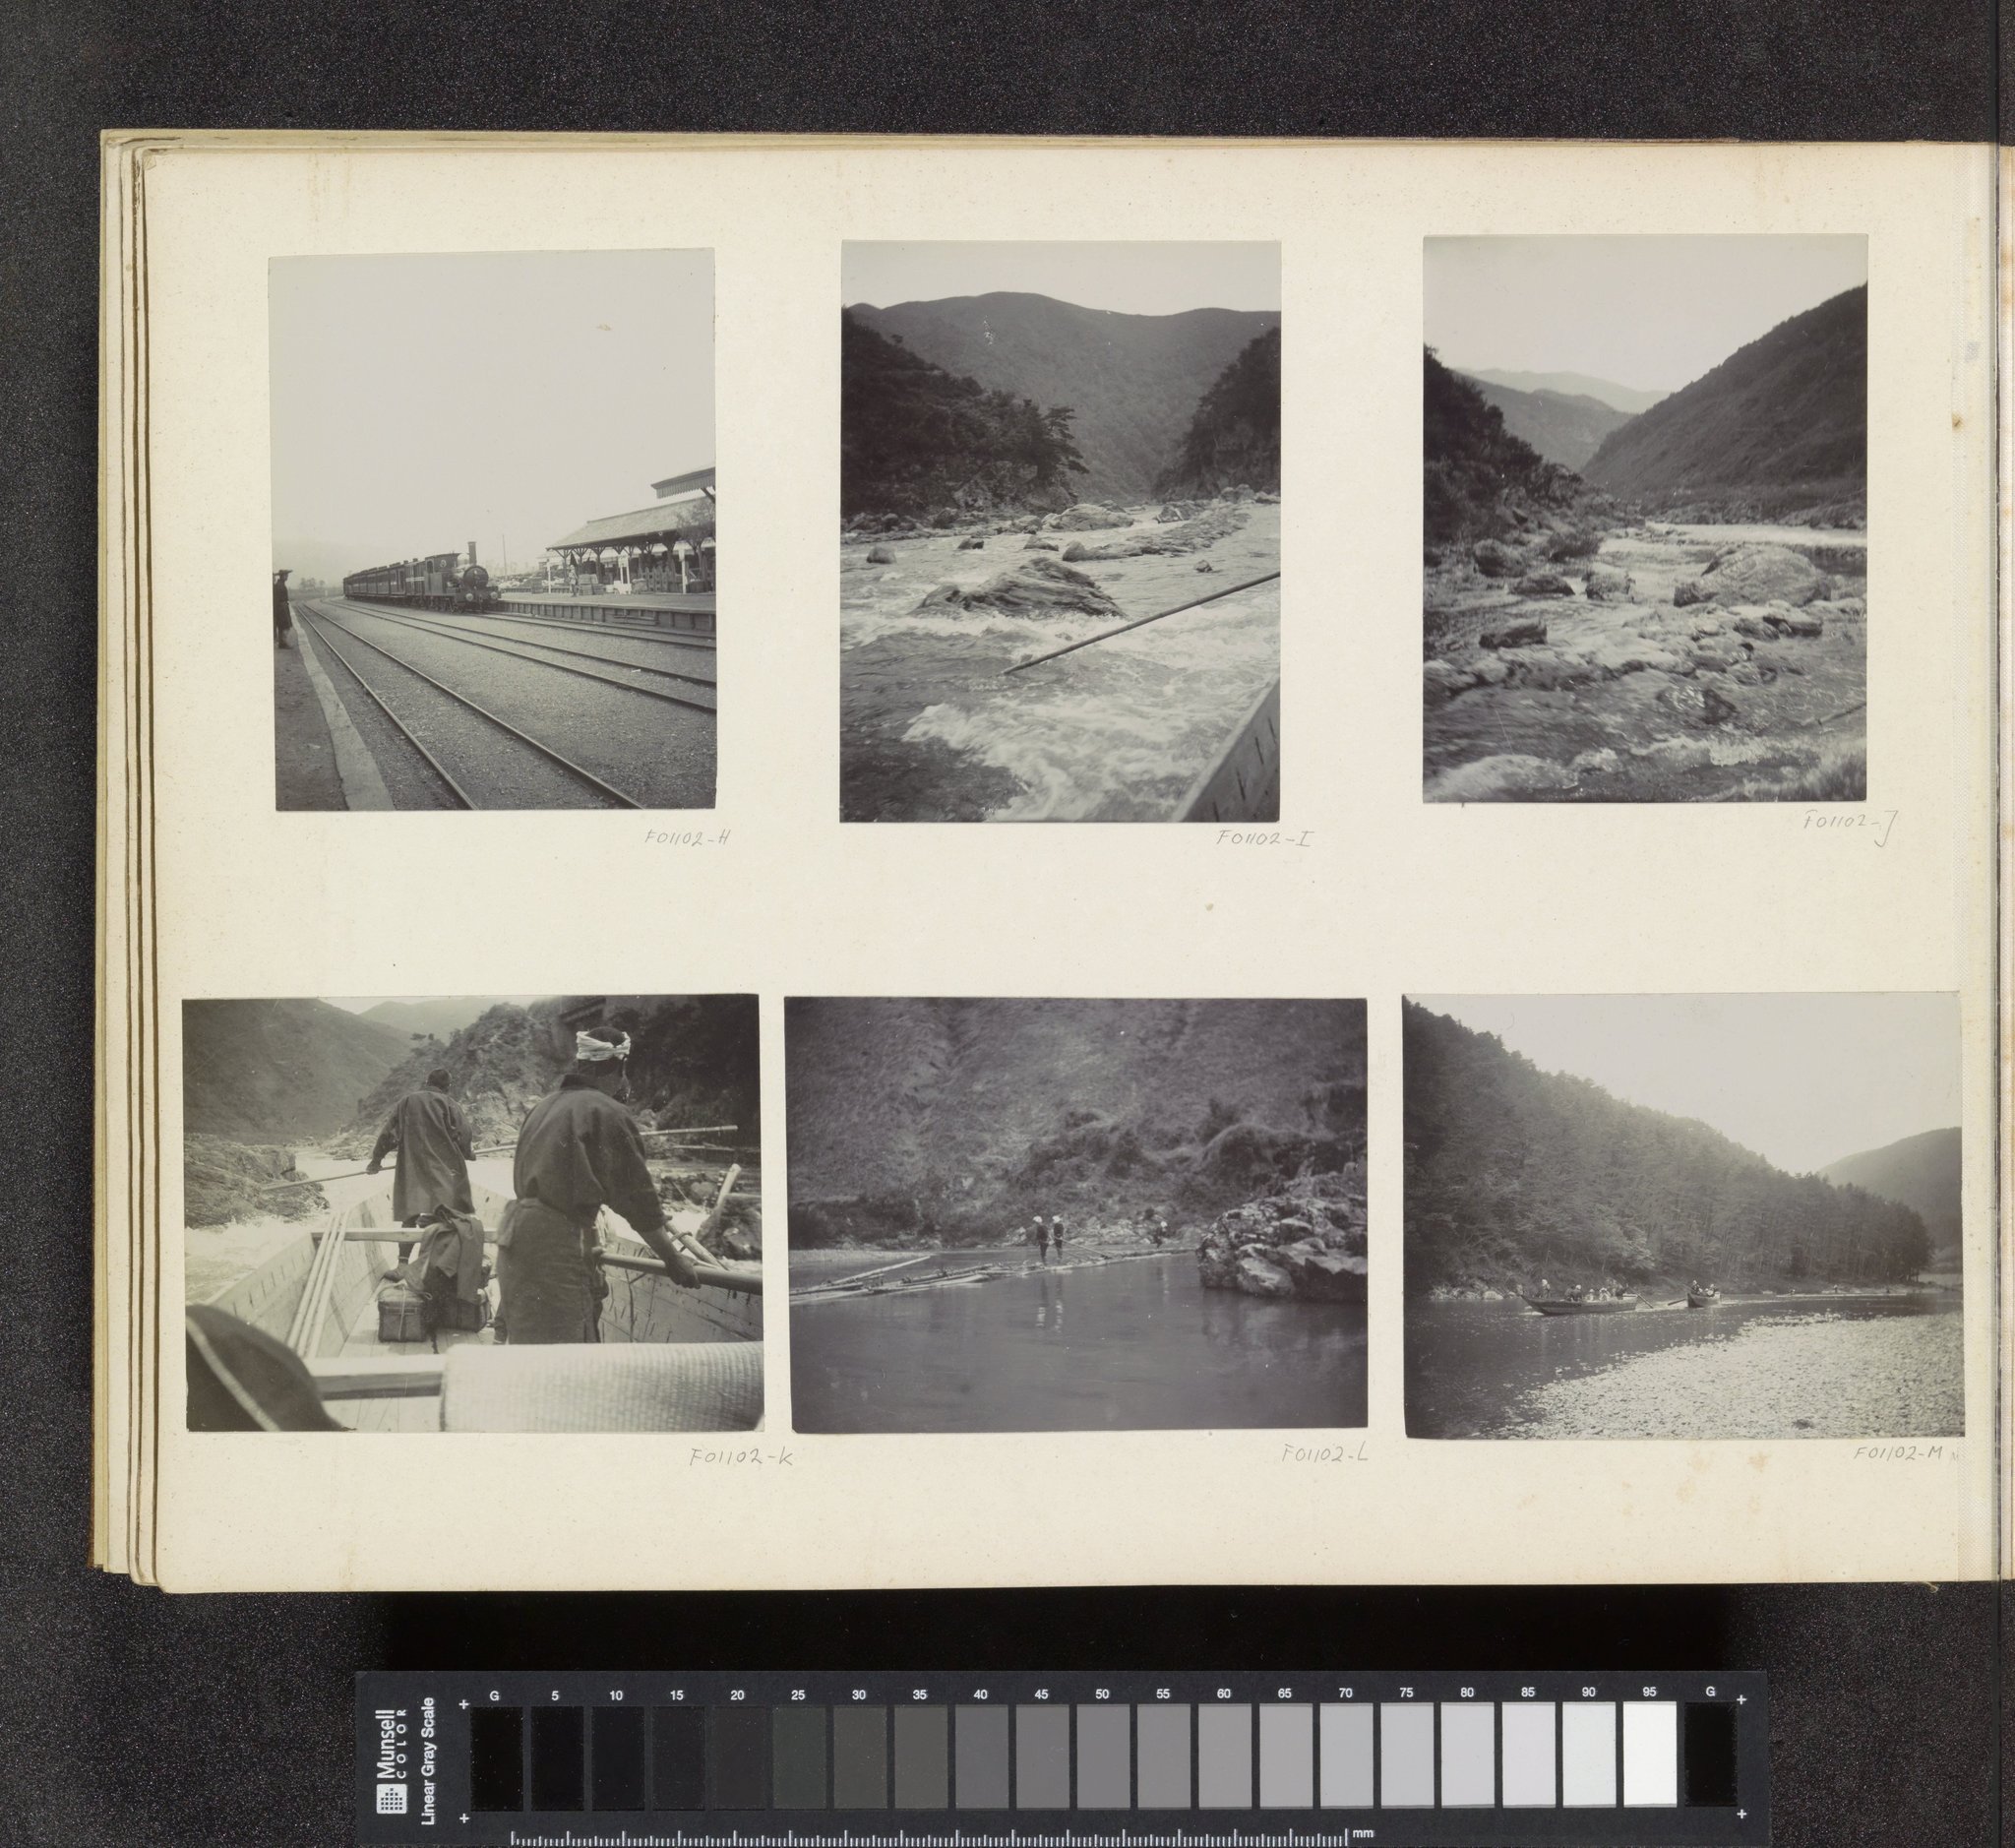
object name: photograph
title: Gezicht op een stroomversnelling in Japan, mogelijk in de Hozurivier op Kyoto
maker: Anonymous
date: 1900-1940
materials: cardboard, paper, photographic support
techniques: gelatin silver print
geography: japan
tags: rapids, japan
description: Onderdeel van Reisalbum met foto's van bezienswaardigheden in Japan.